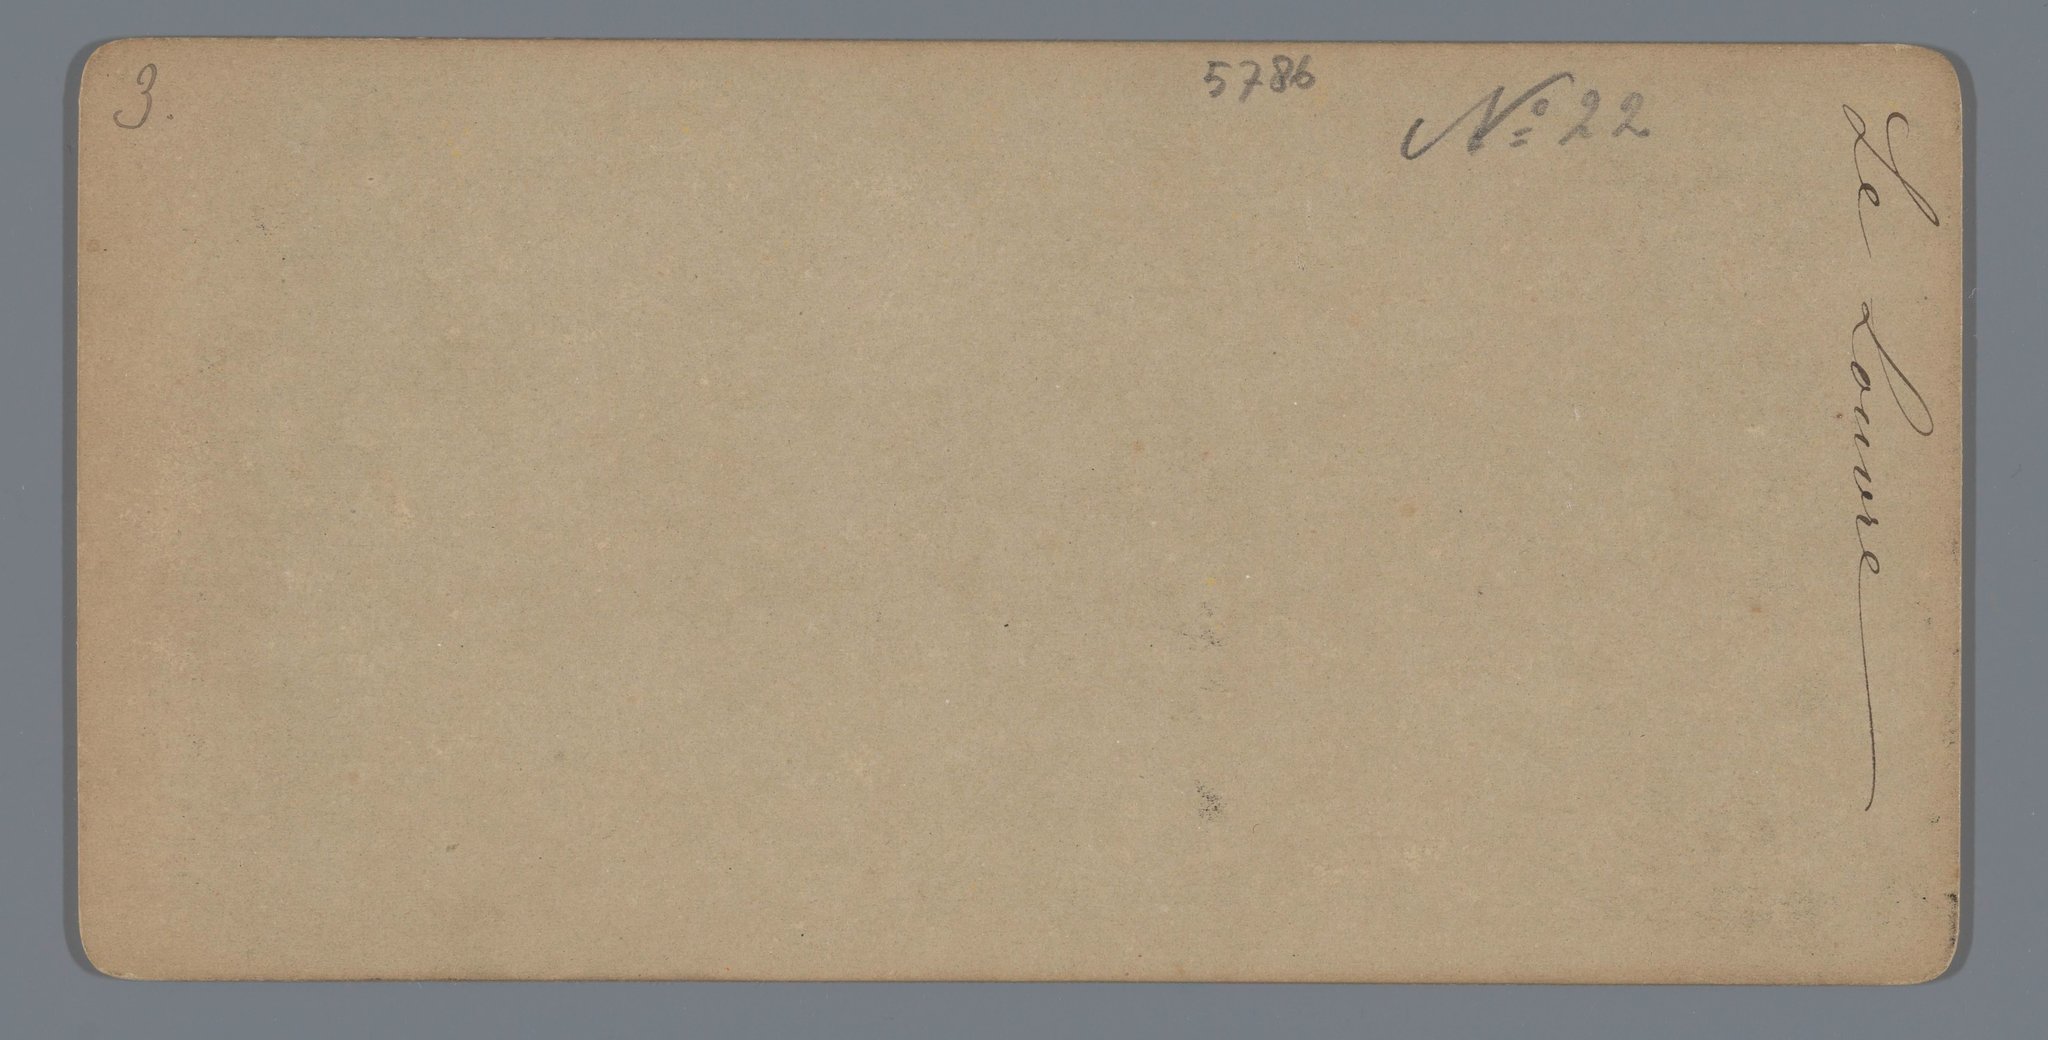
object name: stereograph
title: Gezicht op het Pavillon Richelieu van het Musée du Louvre in Parijs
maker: Anonymous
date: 1850-1880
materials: cardboard, photographic support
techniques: albumen print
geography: paris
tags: permanent exhibition, museum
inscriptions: number: ‘No. 22’, inscription: ‘Le Louvre’, number: ‘3.’